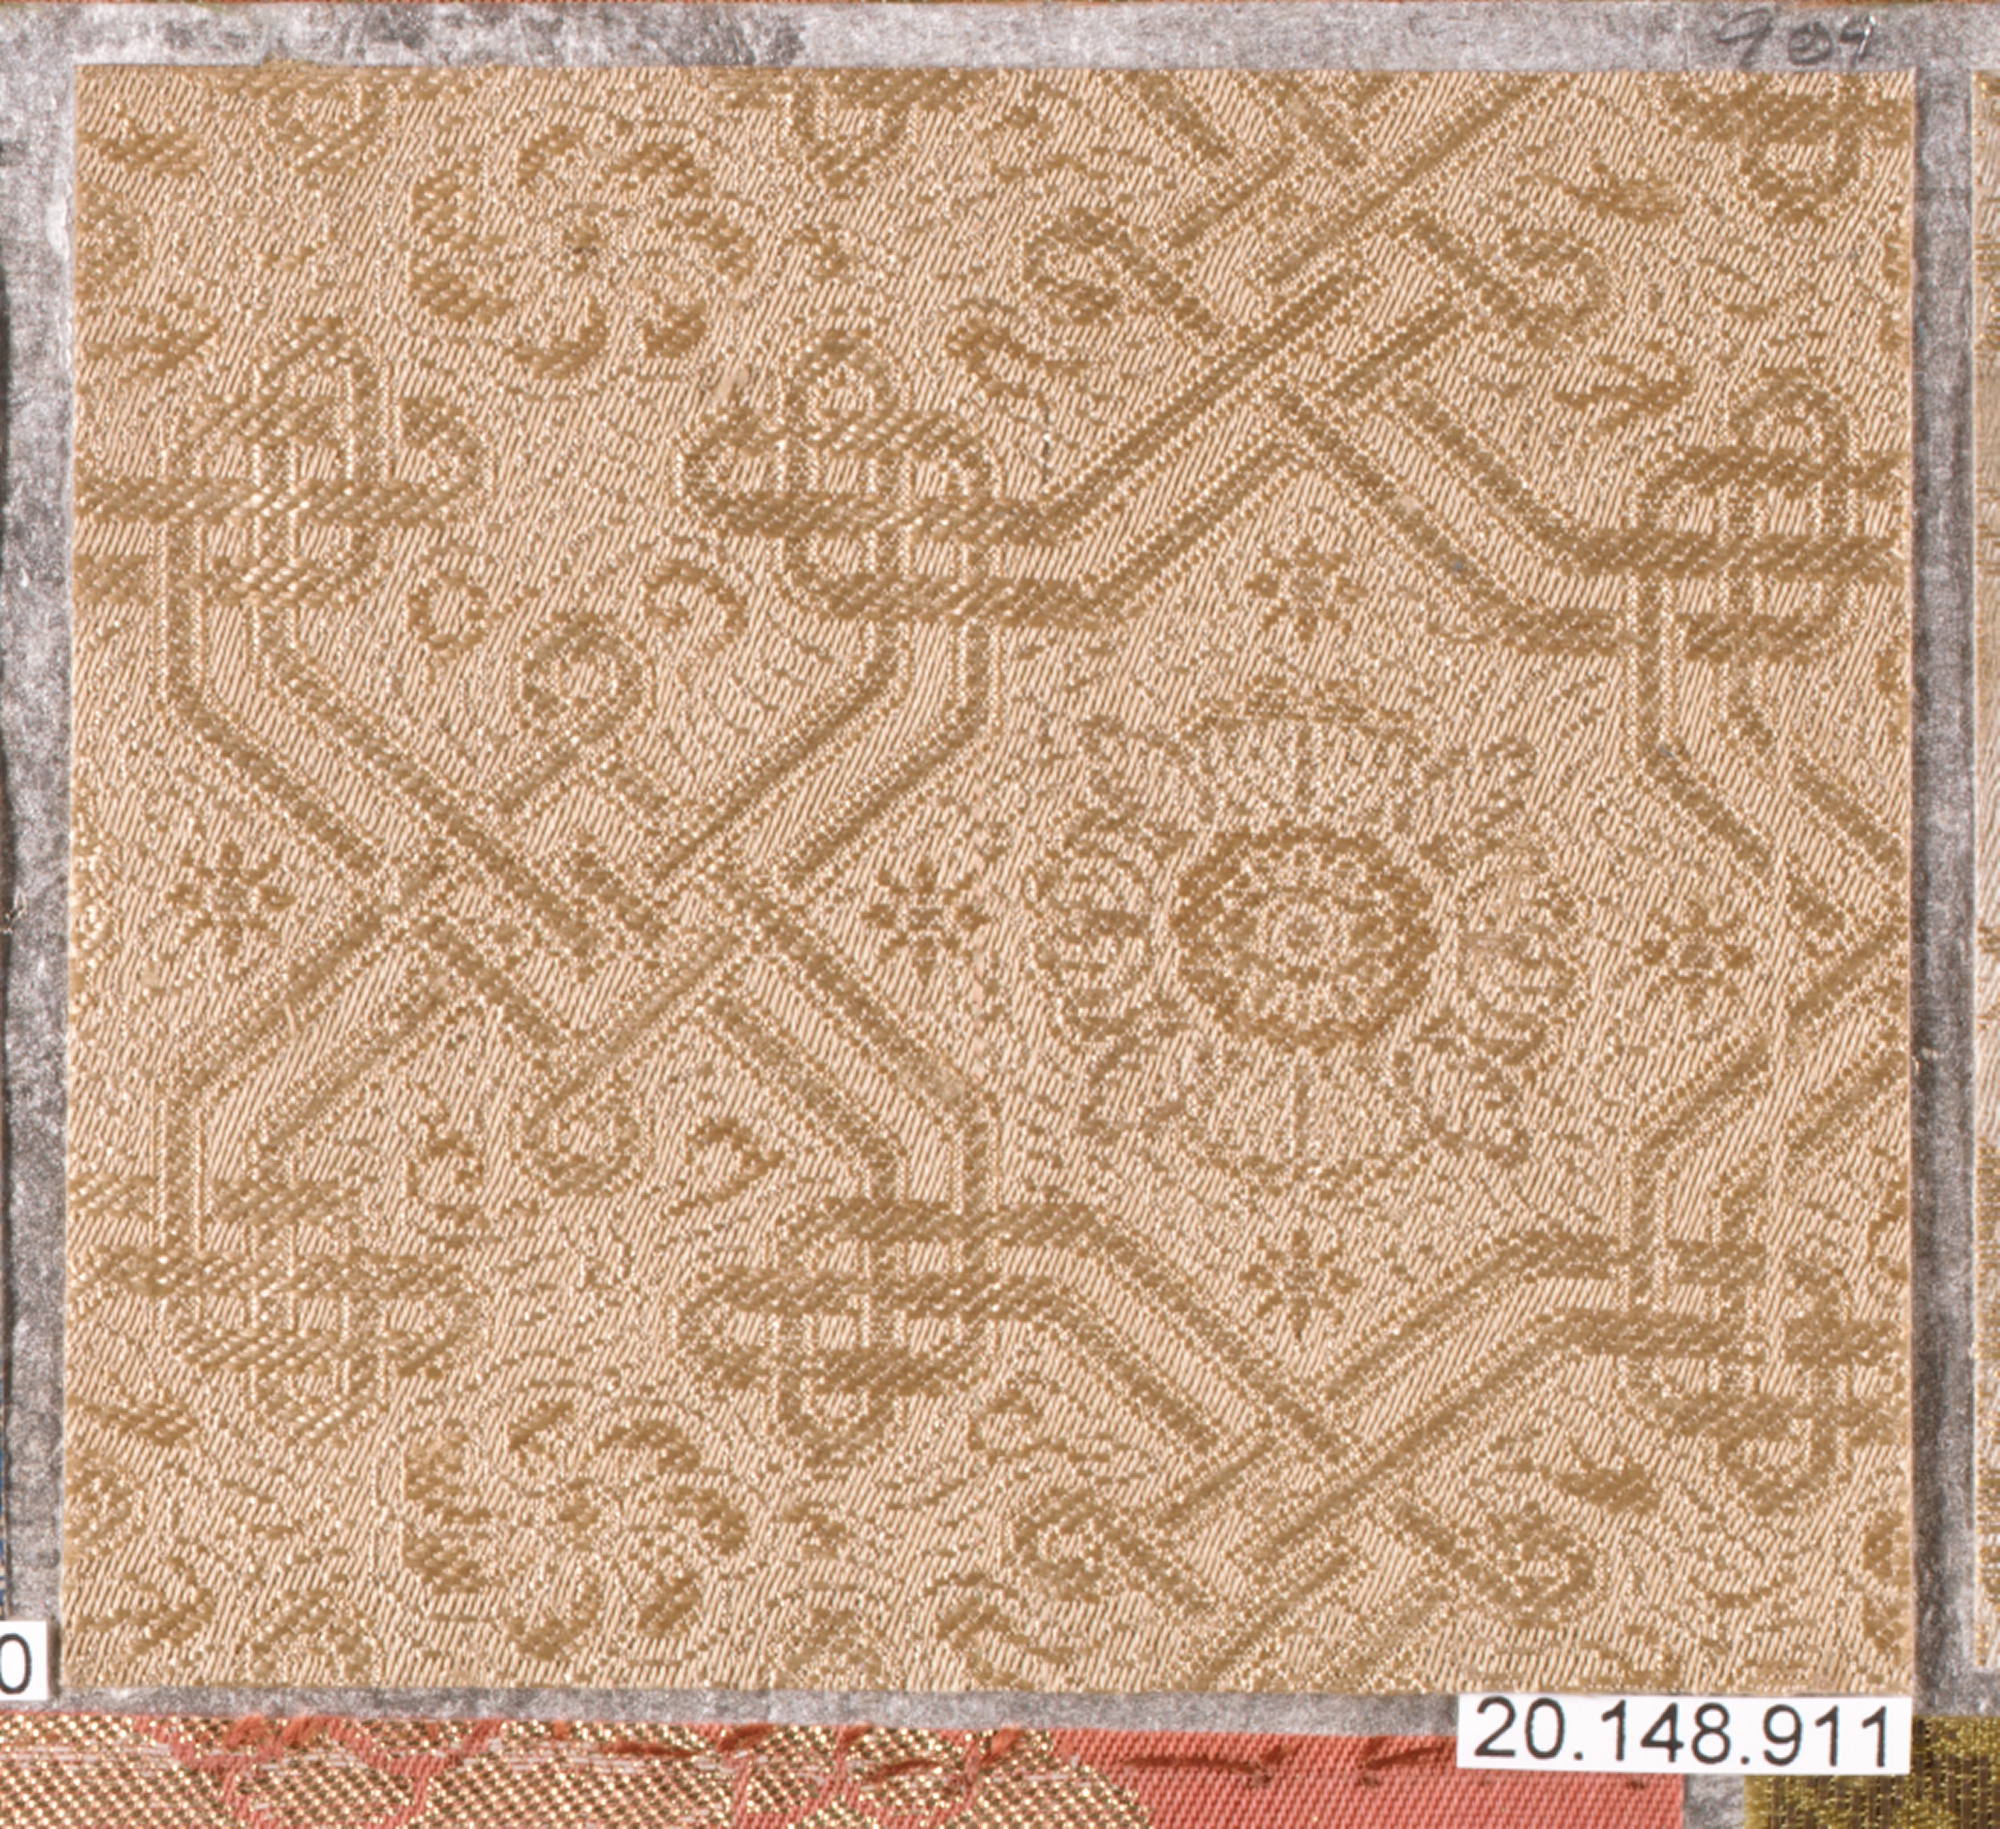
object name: piece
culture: japanese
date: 1801-1900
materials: silk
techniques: compound weave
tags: flowers